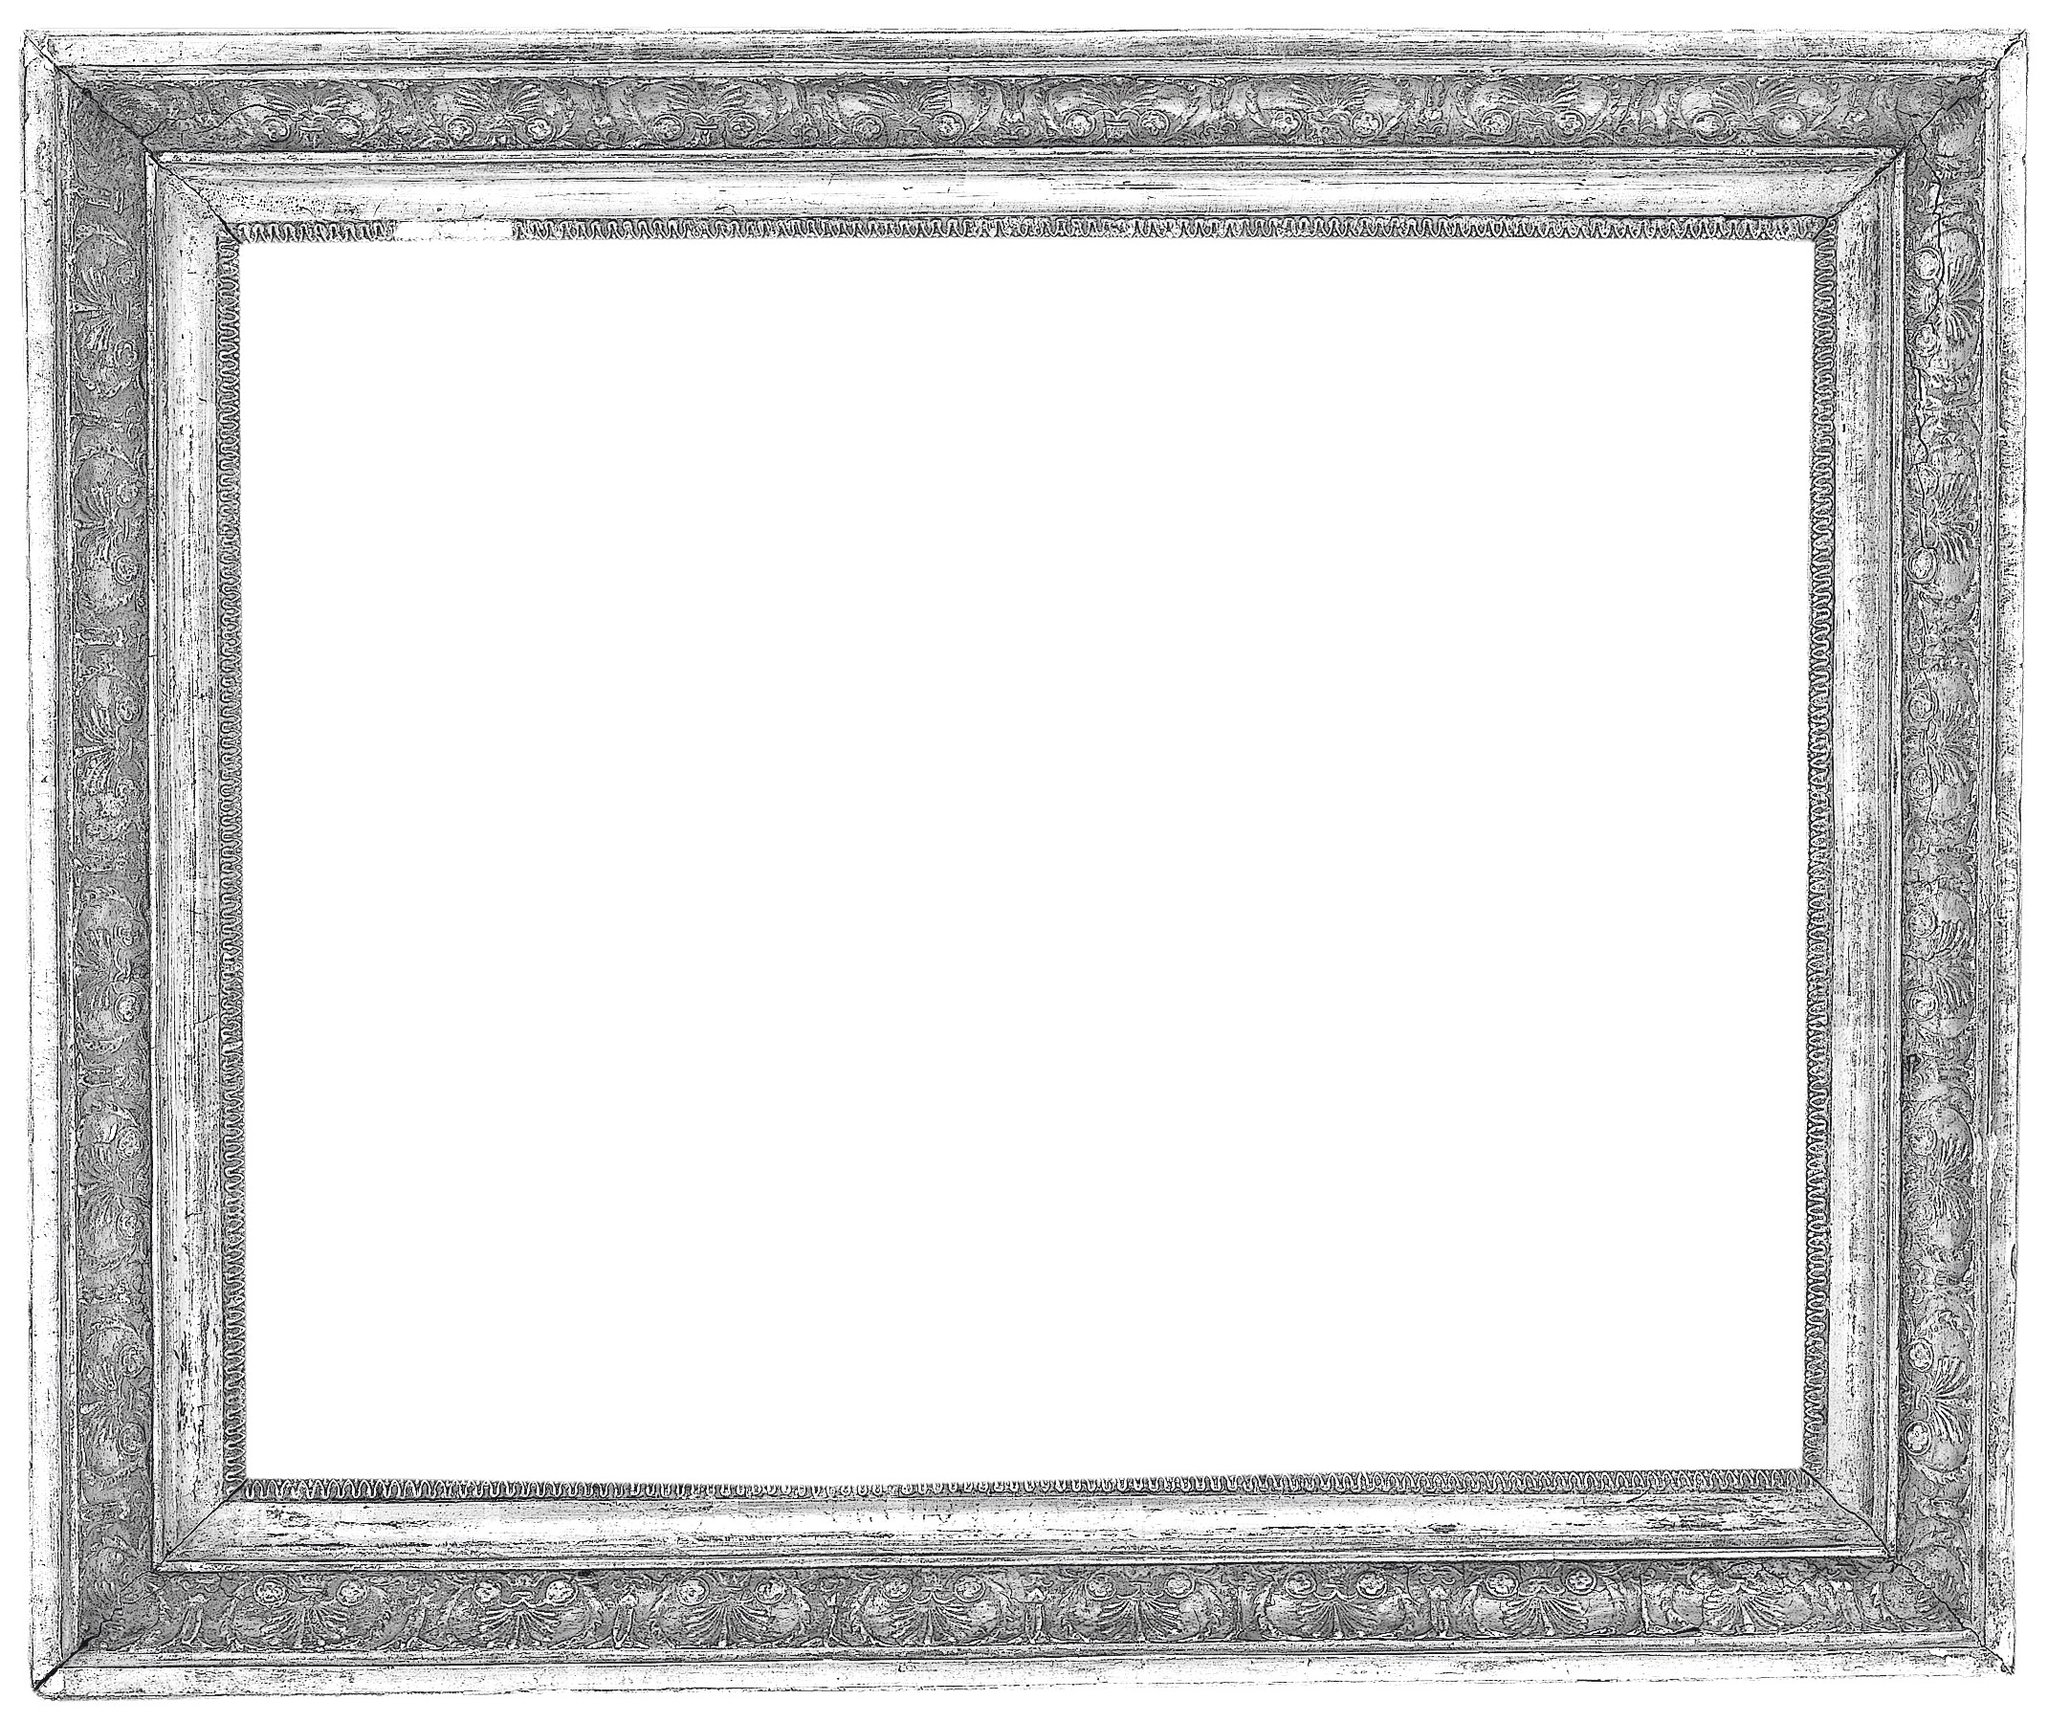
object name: frame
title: Empire frame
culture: british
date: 1815-1820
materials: wood